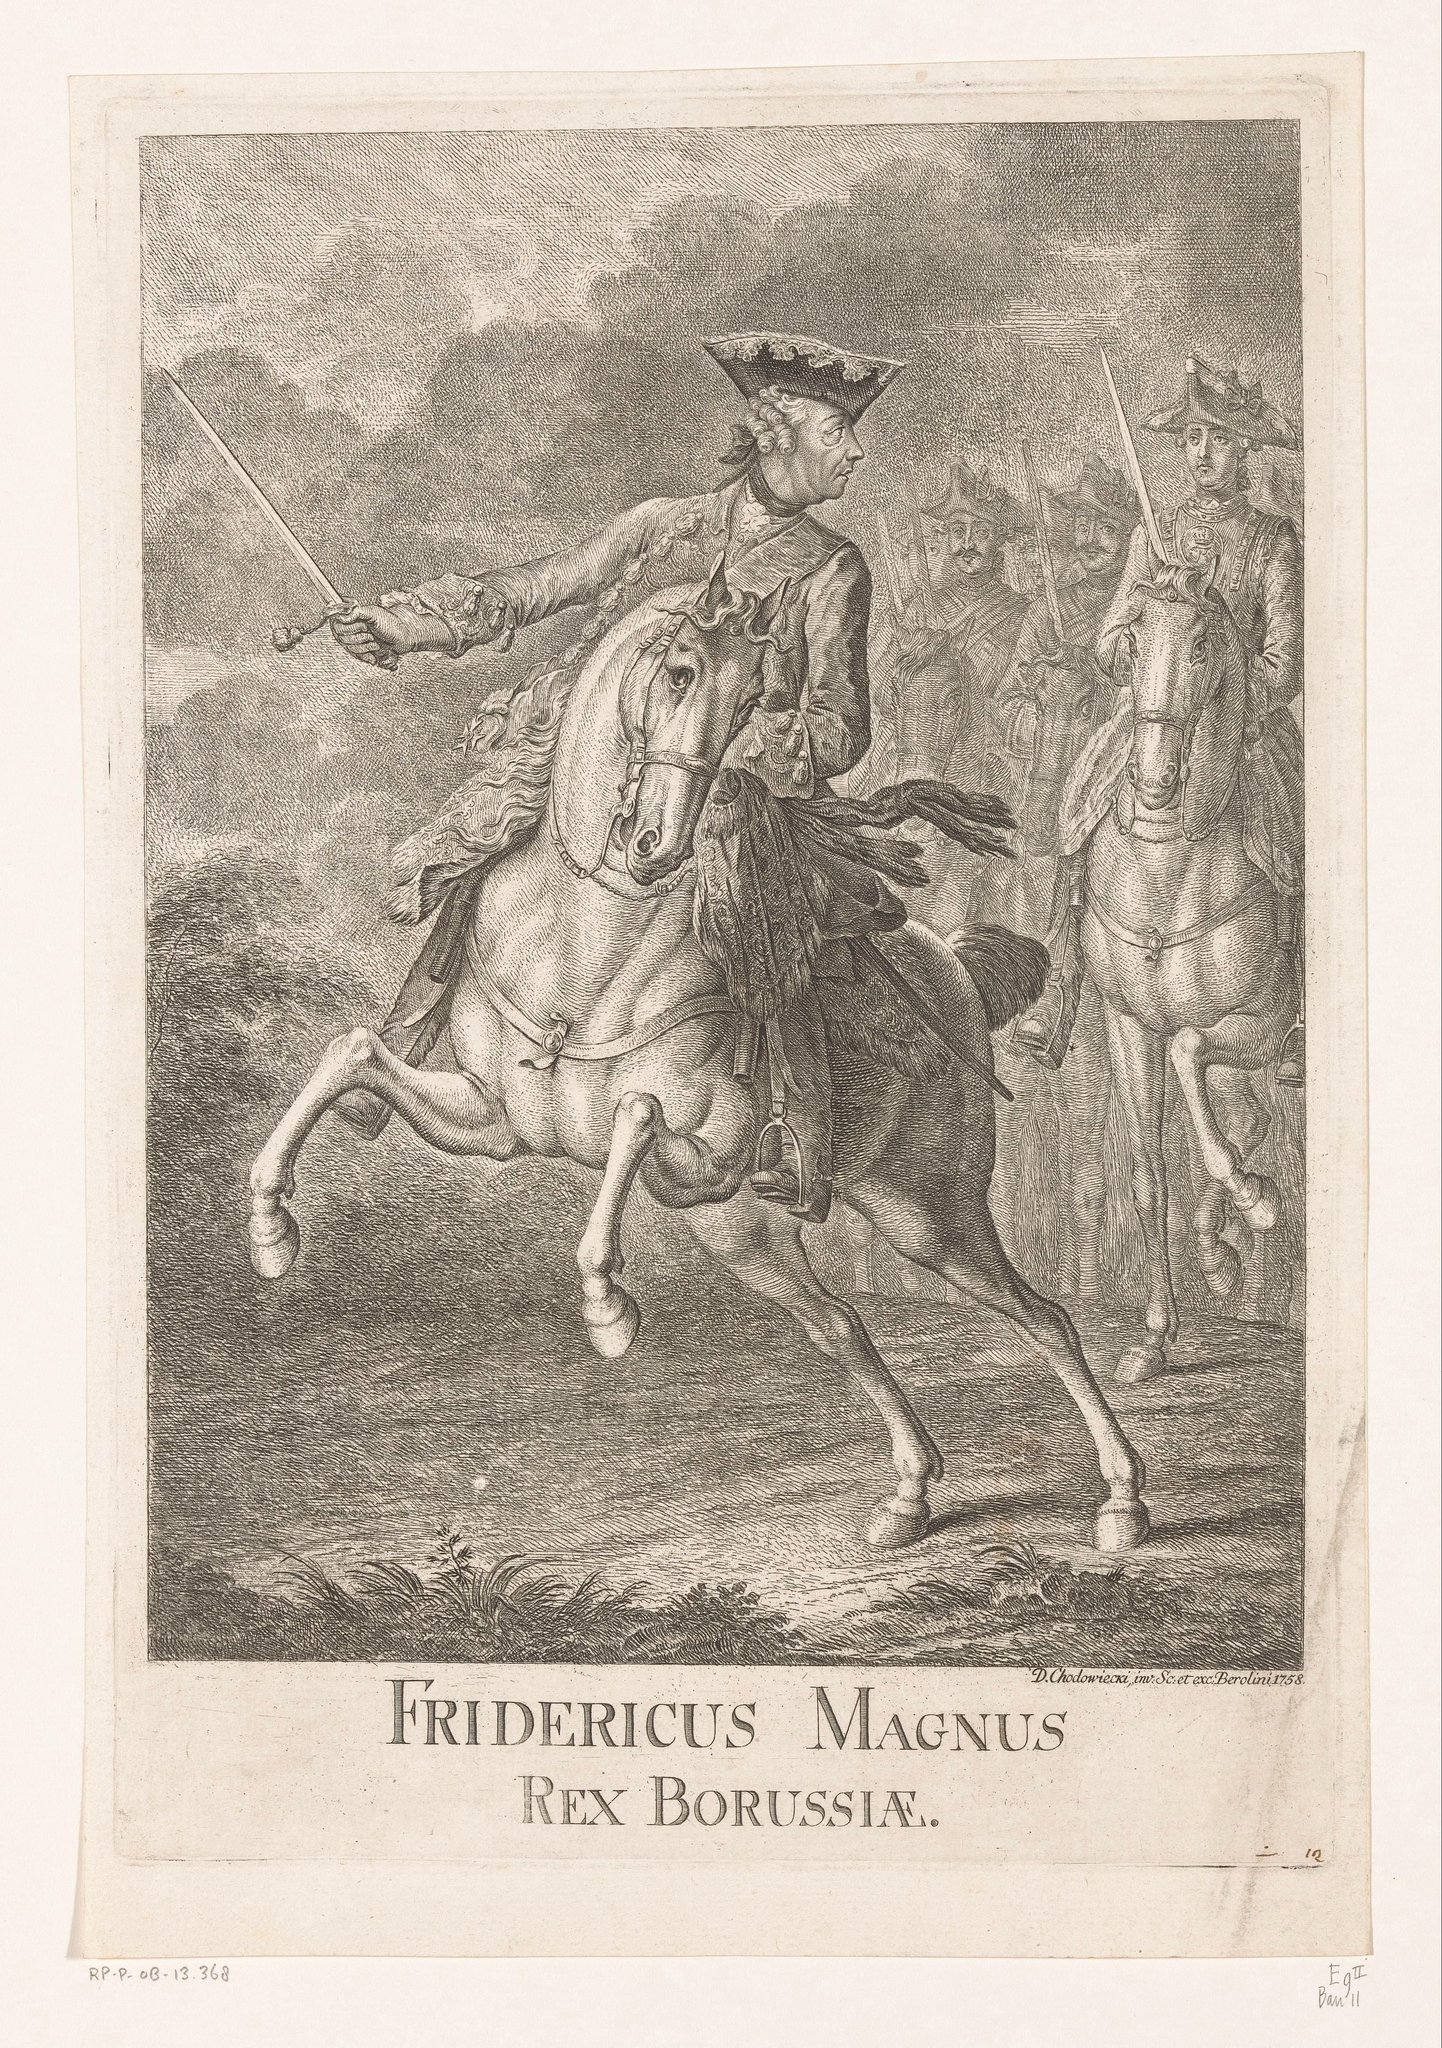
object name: print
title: Frederik de Grote te paard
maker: daniel nikolaus chodowiecki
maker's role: draughtsman, print maker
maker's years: 1726-1801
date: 1758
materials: paper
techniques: etching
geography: berlin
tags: berlin, frederick ii (king of prussia), equestrian state-portrait, riding a horse, ass, or mule; rider, horseman, historical persons, hacking and thrusting weapons: sword, (military) uniforms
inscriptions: number: ‘- 12’, collector's mark: Lugt 700, collector's mark: Lugt 240